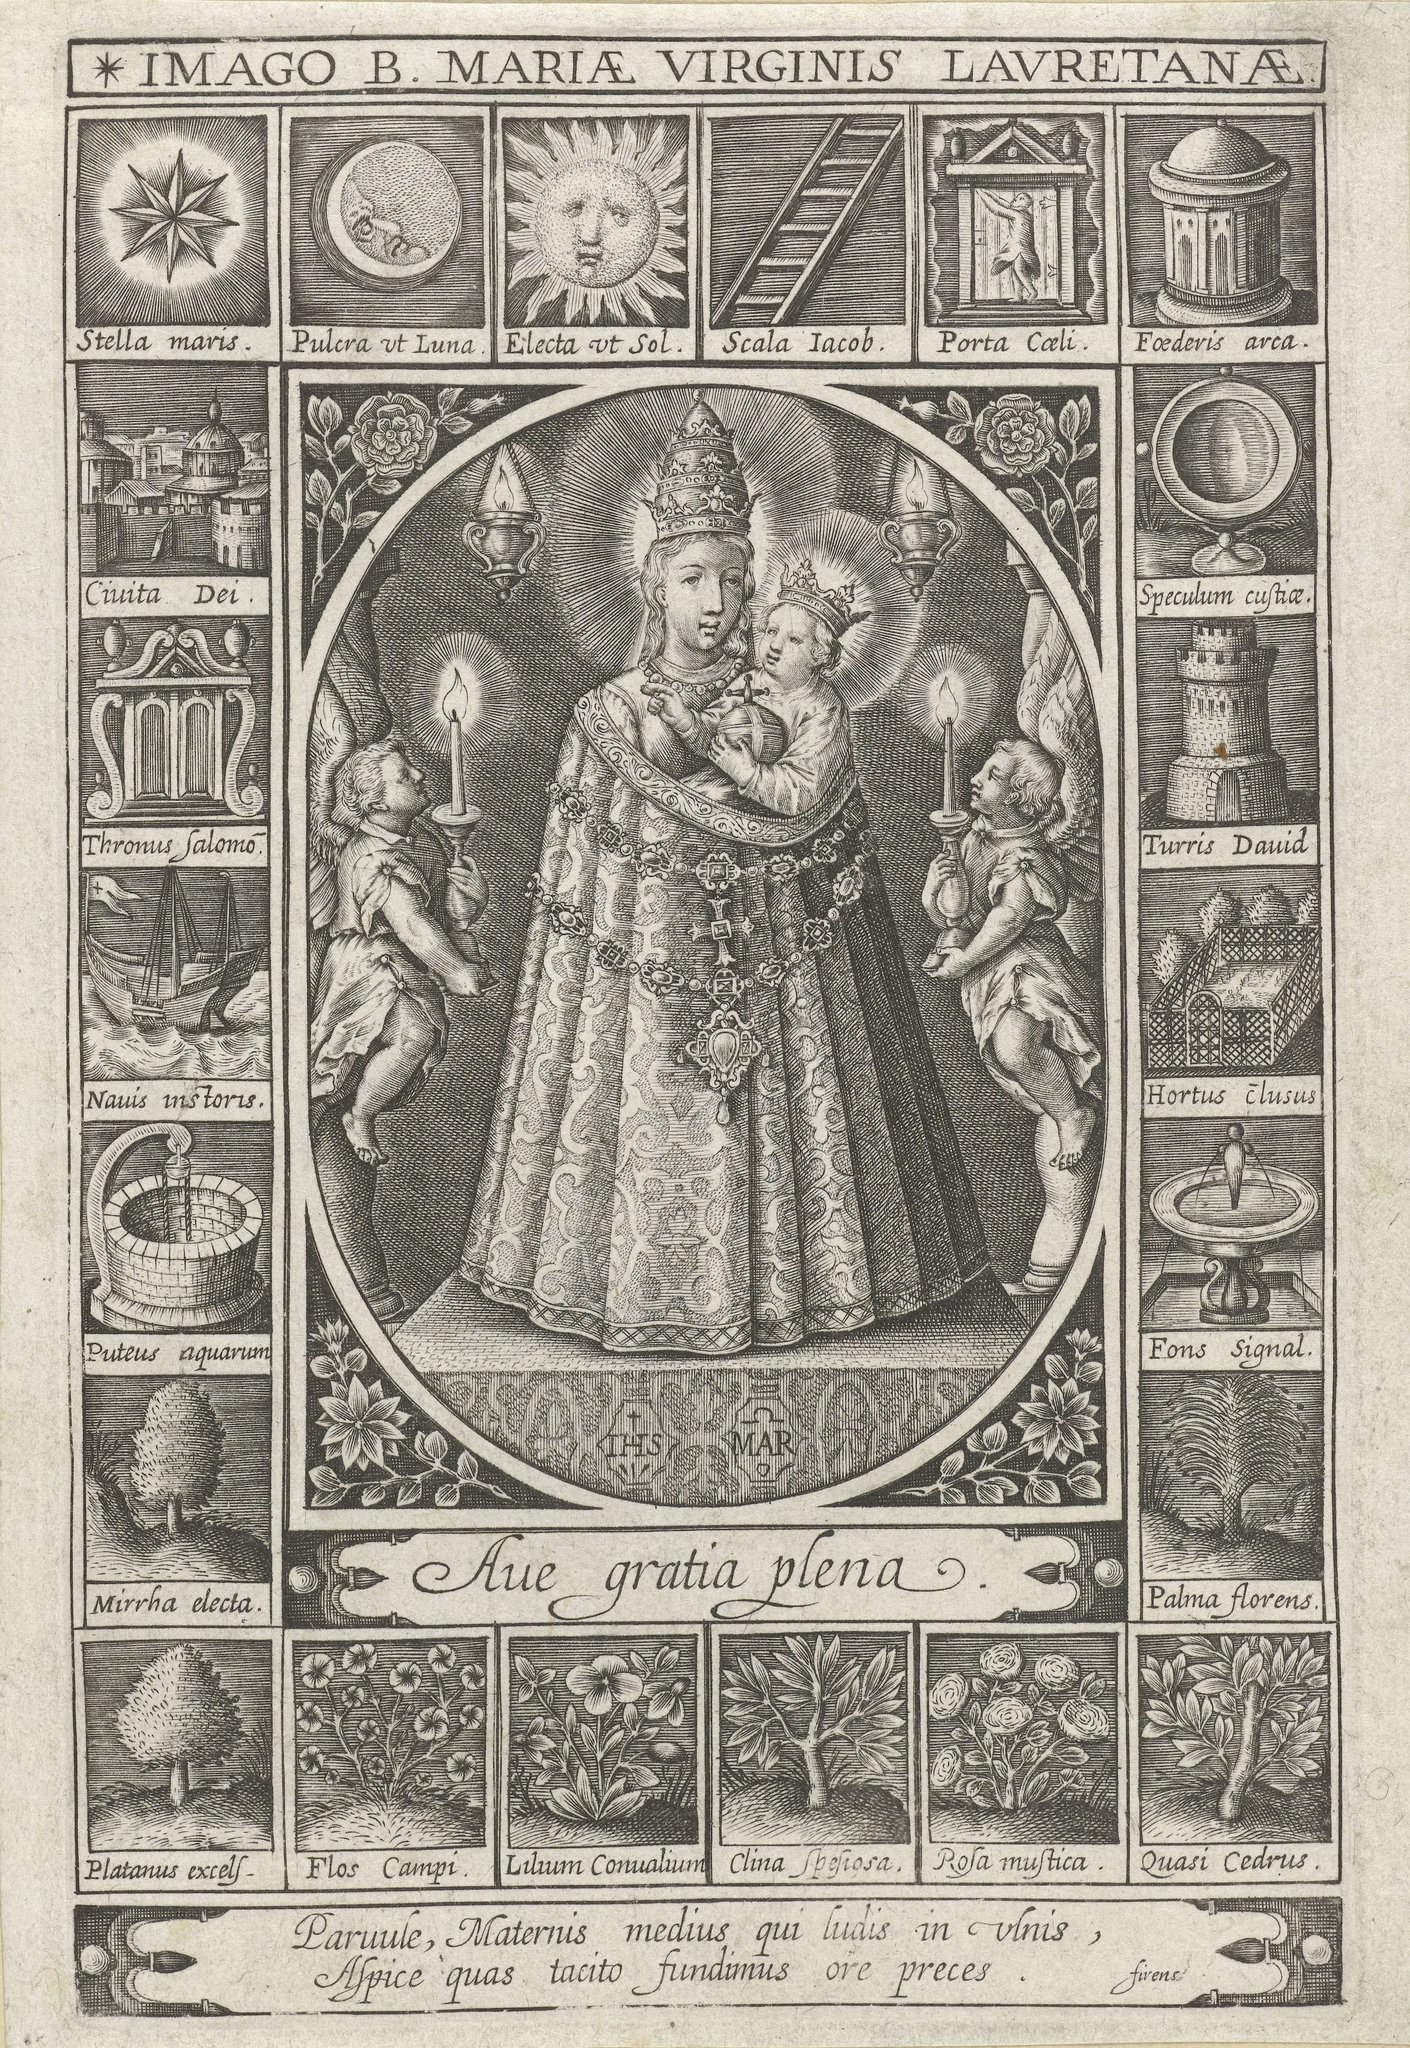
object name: print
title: Devotieprenten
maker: pierre firens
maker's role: print maker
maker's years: 1580-1638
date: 1600-1639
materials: paper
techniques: engraving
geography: paris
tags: mary standing (or half-length), the christ-child on her arm (christ-child to mary's left)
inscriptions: collector's mark: Lugt 845, collector's mark: Lugt 2166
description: Maria, rijk gekleed en met kroon, heeft het Christuskind in haar armen. Christus draagt een kroon en heeft een rijksappel vast. Maria en Christus worden geflankeerd door twee engelen met een brandende kaars. Rondom de voorstelling 22 cartouches met Christelijke iconografie. Lauretaanse lithanie.